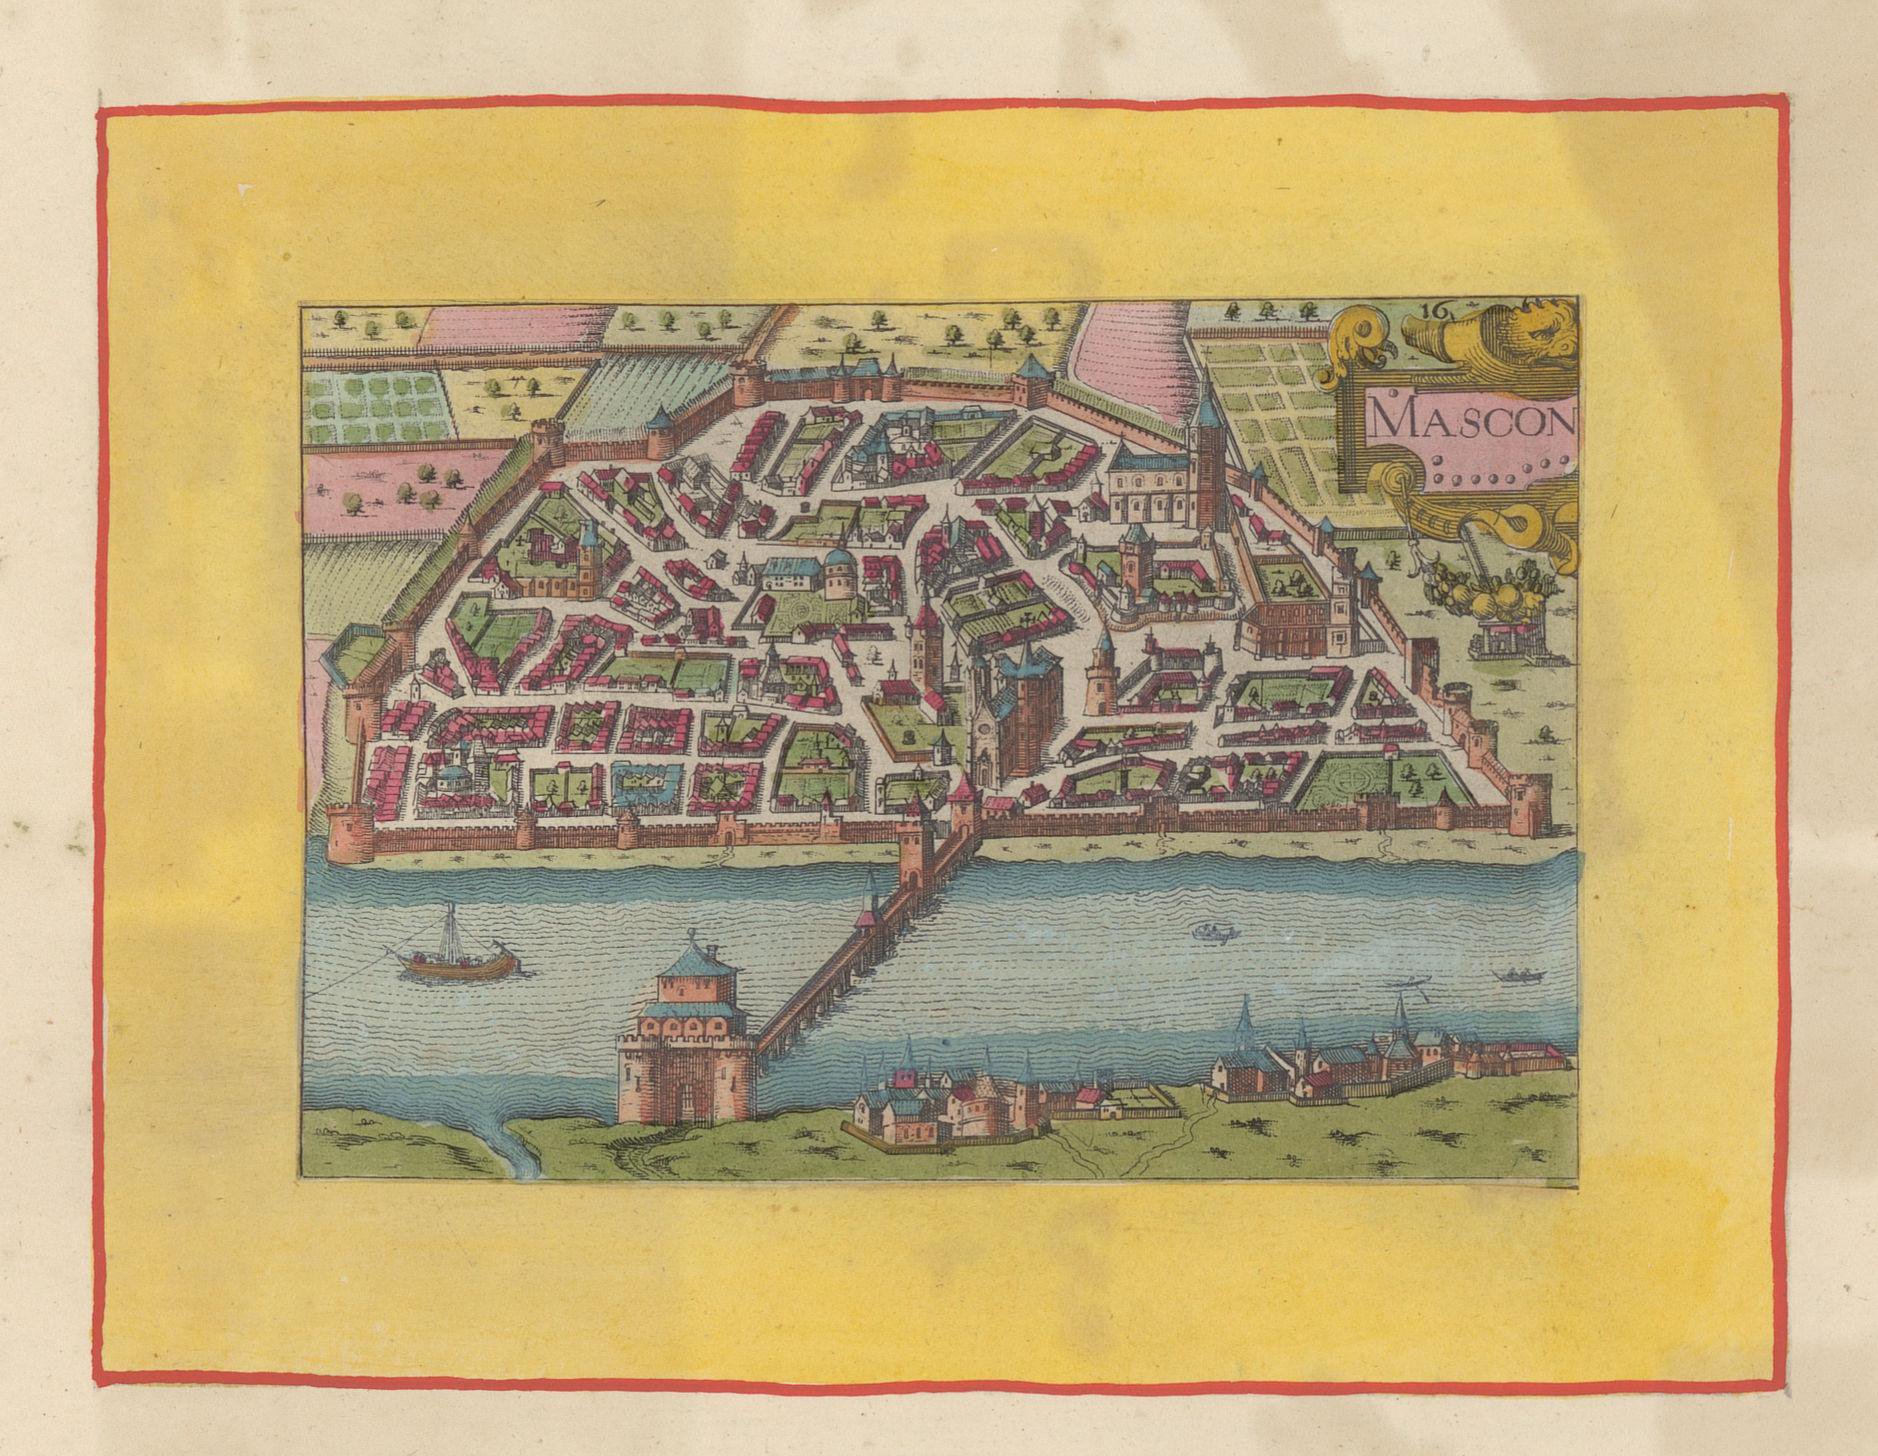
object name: album leaf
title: Gezicht op Mâcon in vogelvluchtperspectief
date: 1638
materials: paper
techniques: engraving, etching, hand coloring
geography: the hague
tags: maps of cities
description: Prent uit: Tassin, Christophe. Les plans et profils de toutes les principales villes et lieux considérables de France (...). Parijs: Michel van Lochom, 1638, kaart 16 uit het deel 'Bourgongne'.